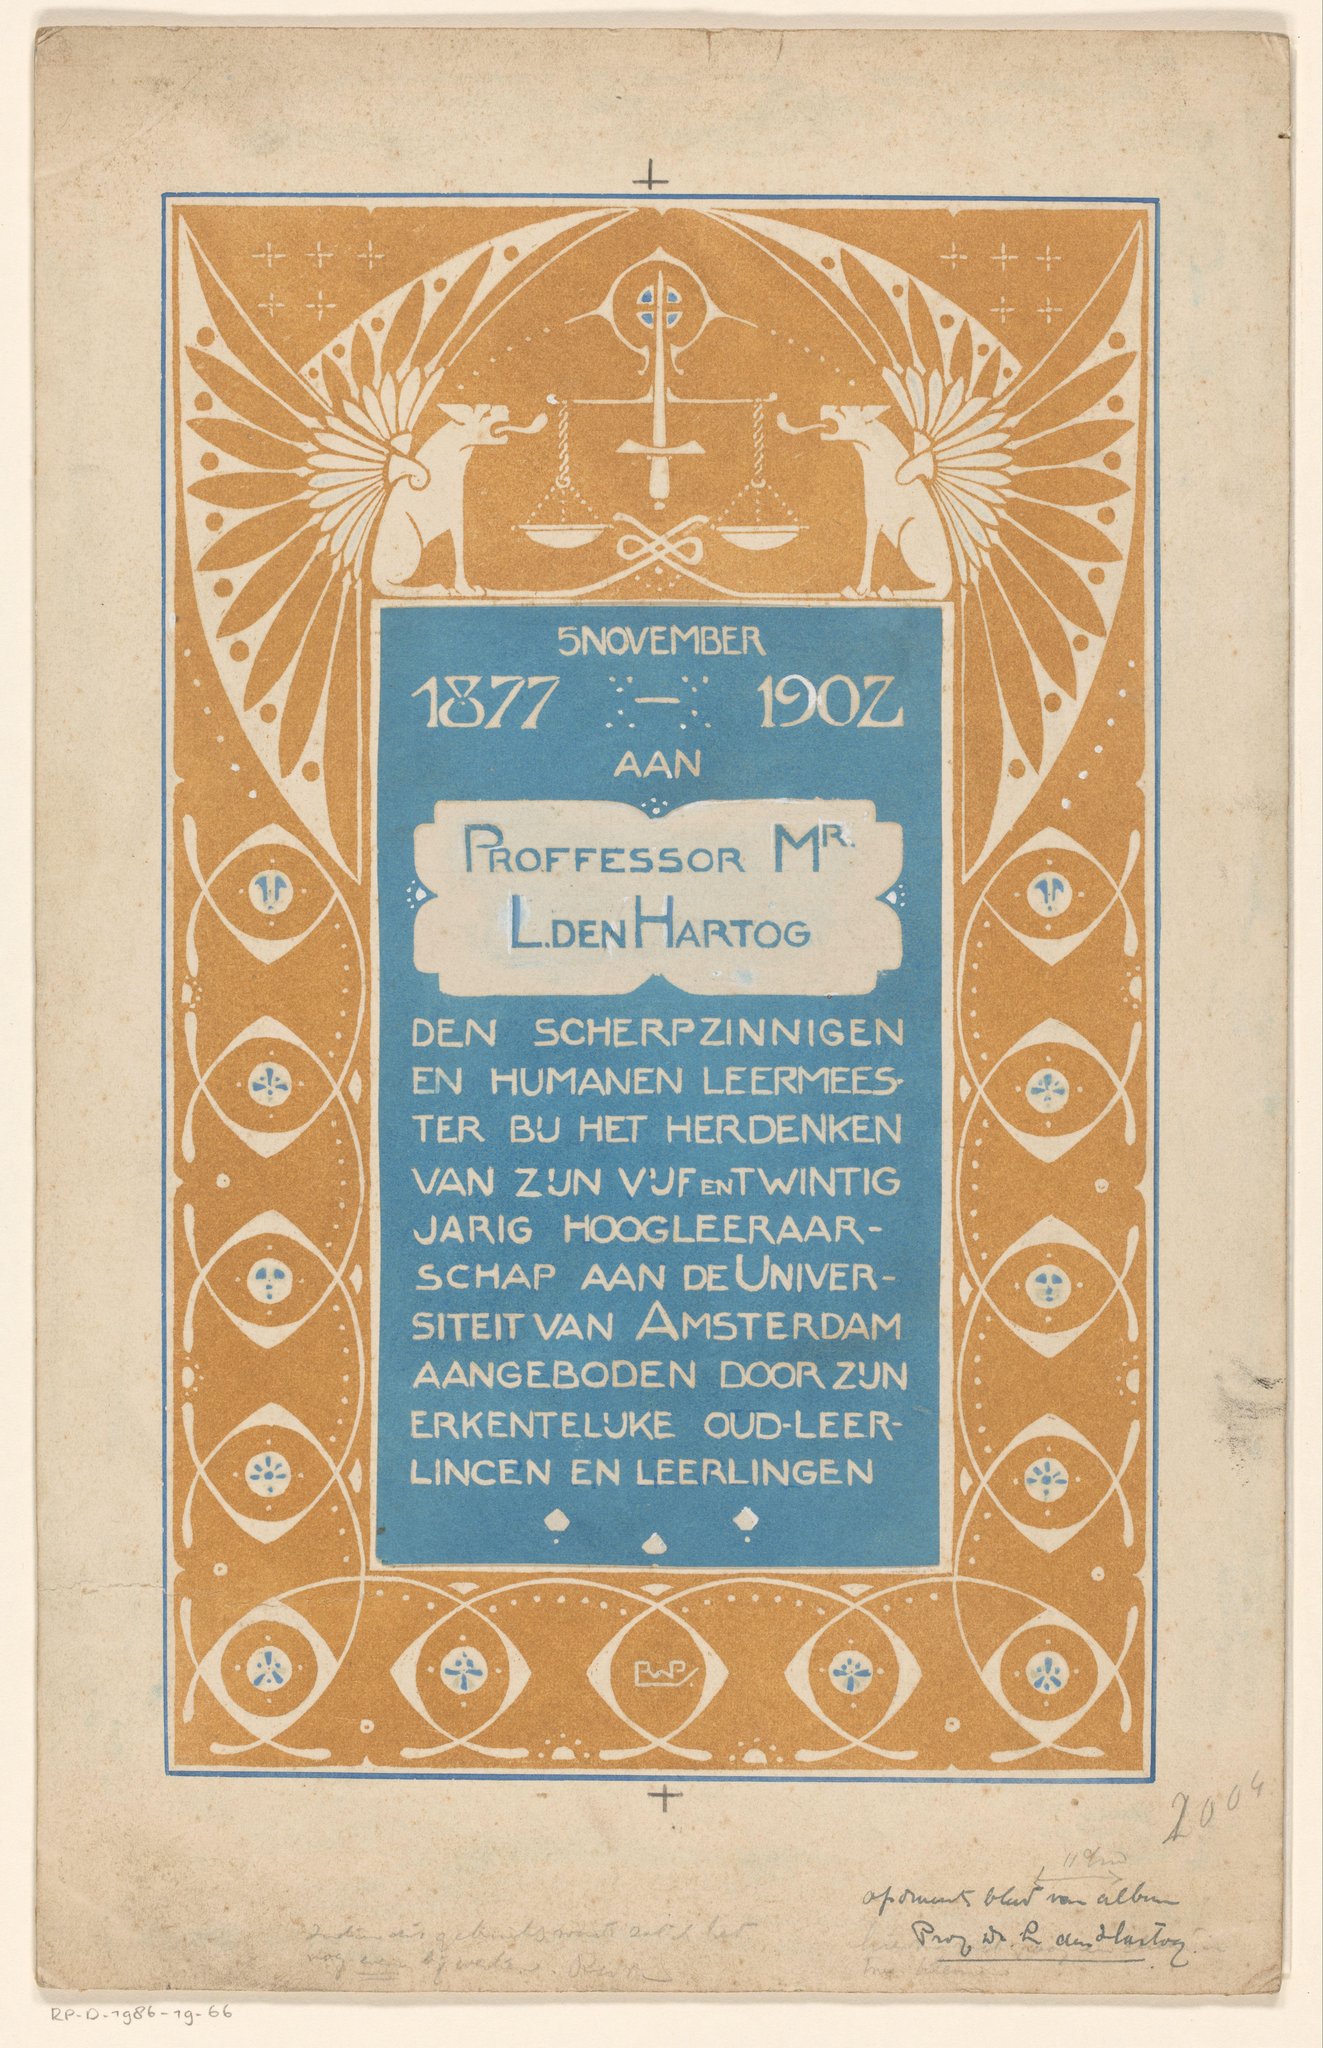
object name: print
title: Opdrachtblad voor een album voor Prof. Mr. L. den Hartog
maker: reinier willem petrus de vries (1874-1953)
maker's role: draughtsman, print maker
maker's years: 1874-1953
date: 1902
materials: paint, paper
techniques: brush, lithograph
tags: ornament derived from animal forms, scales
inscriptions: annotation: ‘Indien dit gebruikt wordt zal ik het/ nog even bij werken. RWP’, annotation: ‘opdracht blad van album/ Prof Dr L den Hartog’, collector's mark: ‘R:MVS.’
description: Rechthoekig kader met daarin de opdracht aan Prof. Mr. L. den Hartog. Bovenaan het kader twee gevleugelde dieren aan weerszijden van een weegschaal.